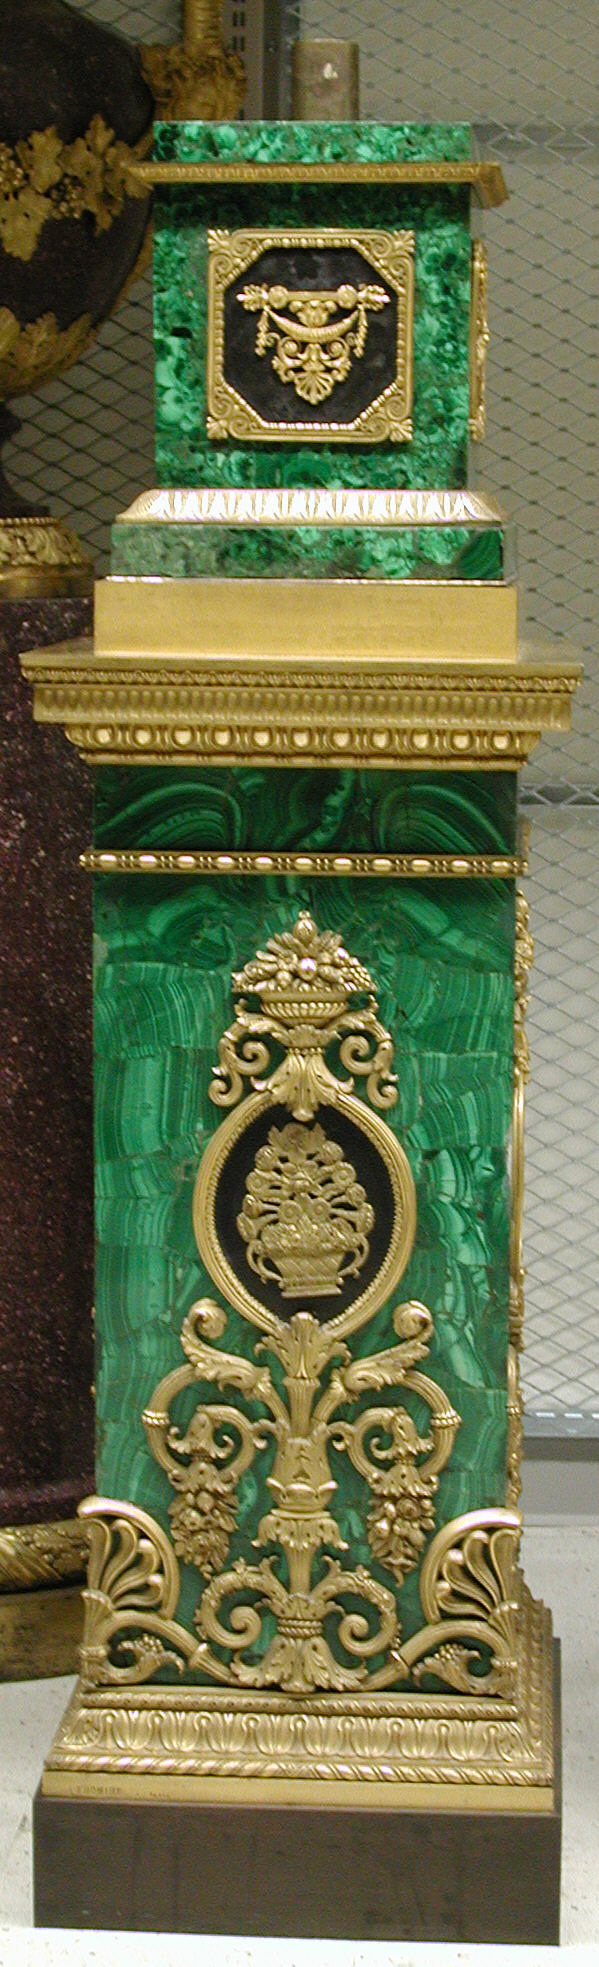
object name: torchère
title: Twelve-light torchère (one of a pair)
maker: pierre philippe thomire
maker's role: maker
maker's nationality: french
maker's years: 1751-1843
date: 1840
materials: bronze, copper, gilt bronze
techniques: veneering